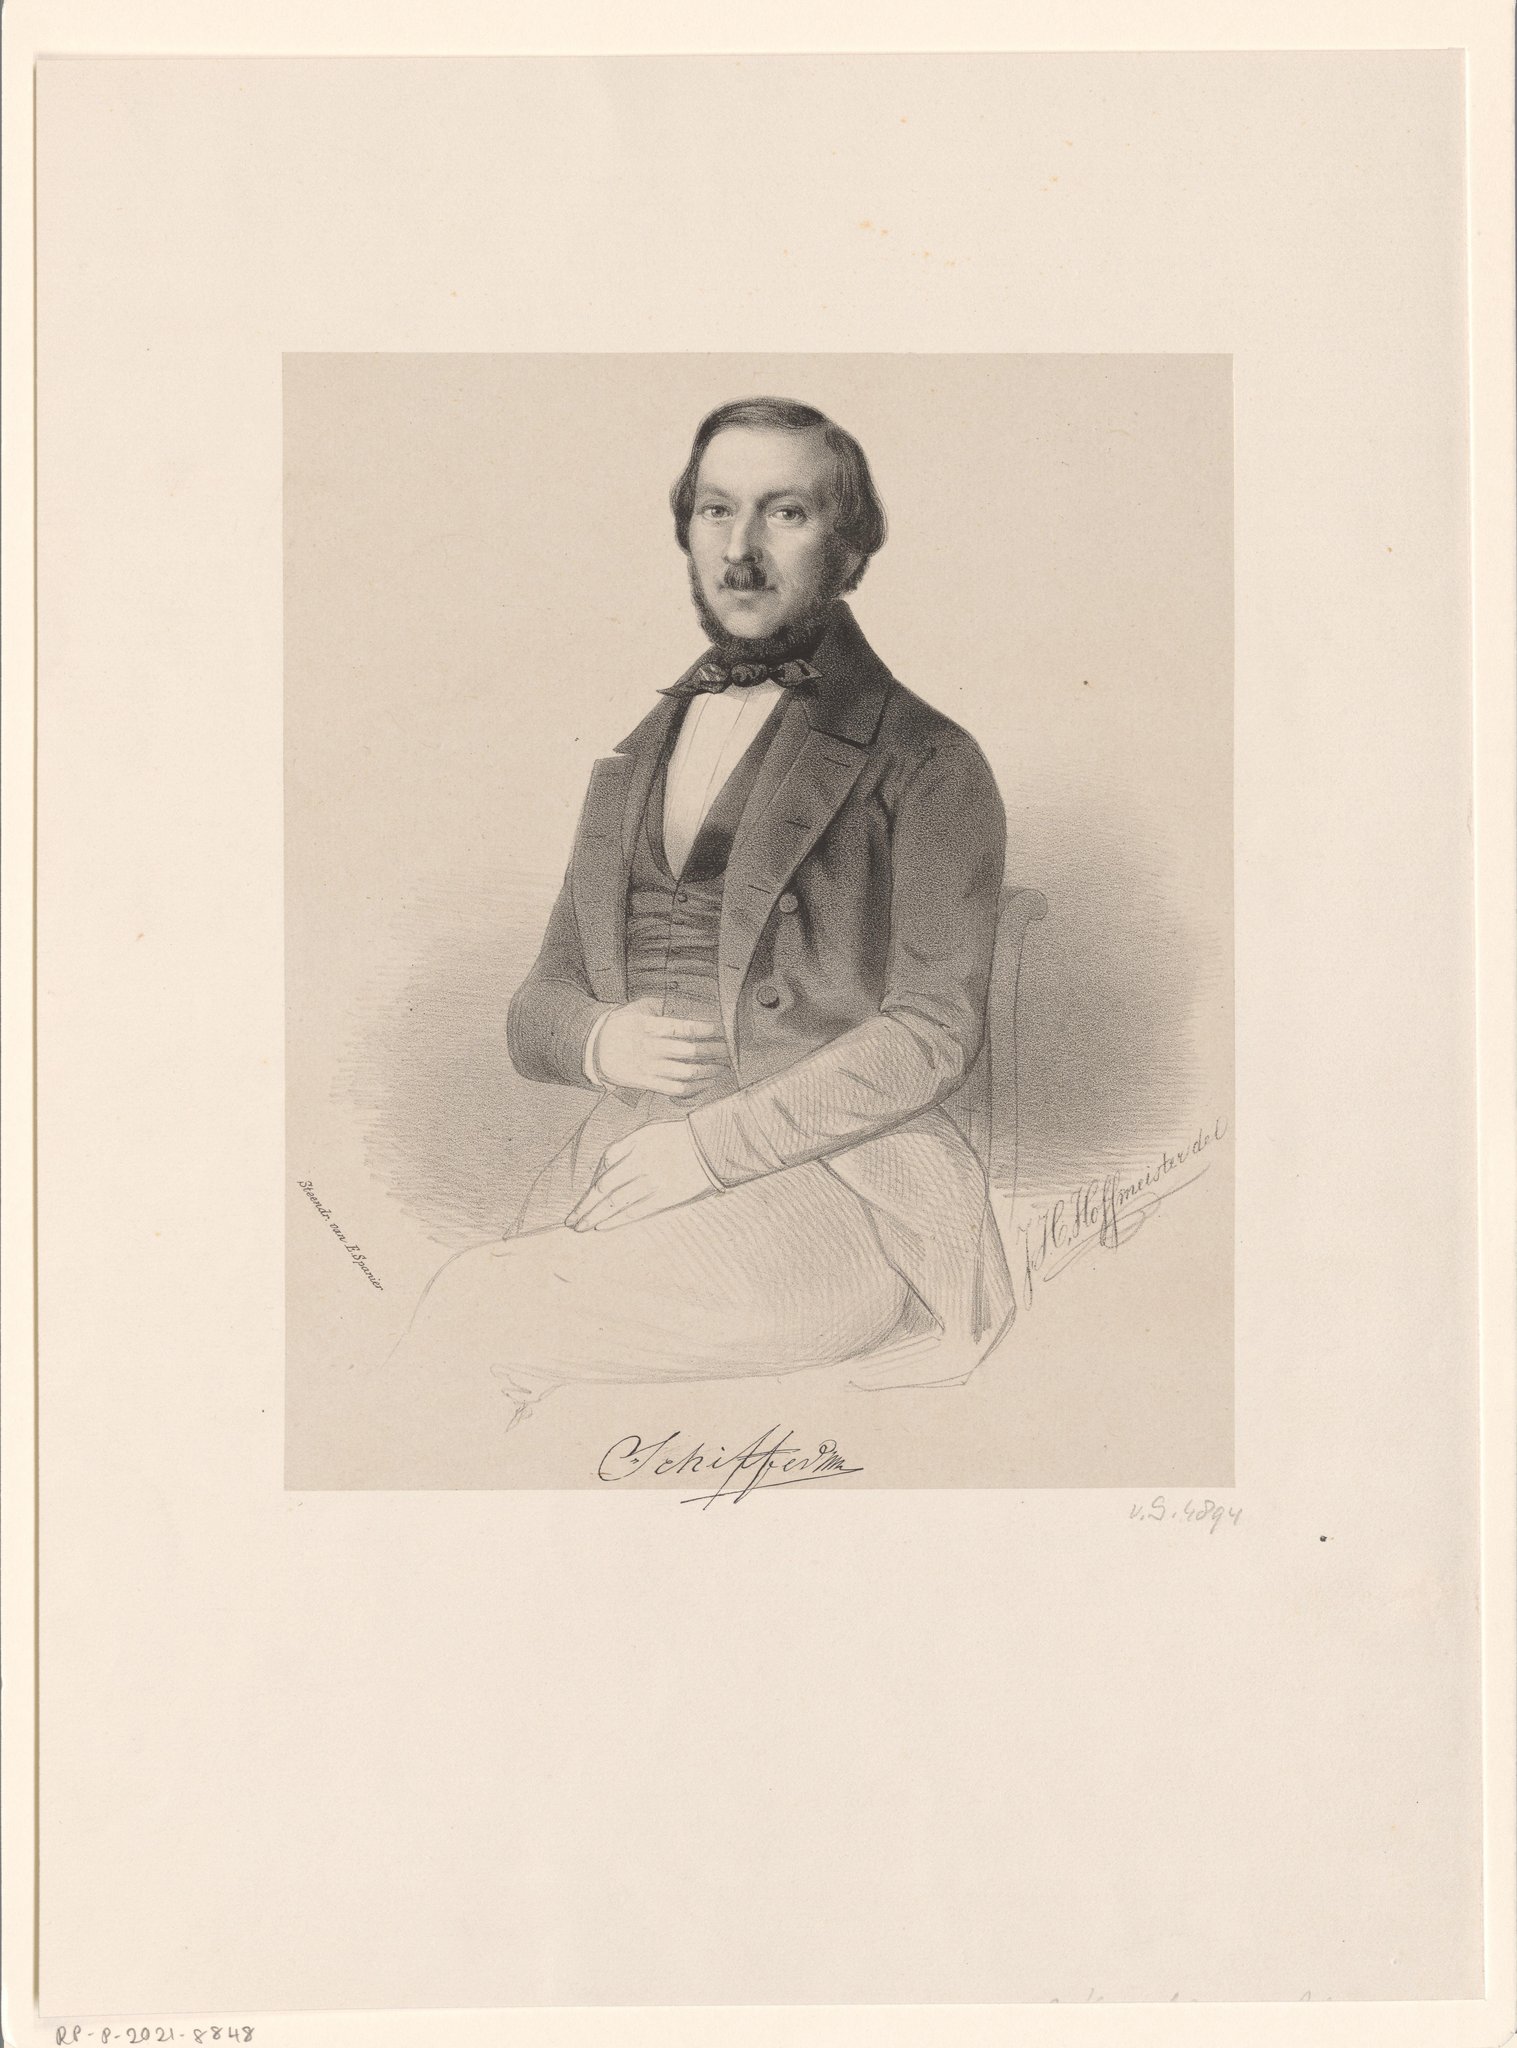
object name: print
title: Portret van Cornelis Schiffer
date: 1843-1863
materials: paper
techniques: lithograph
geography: the hague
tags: manufacturer, historical persons, politician, e.g. party leader